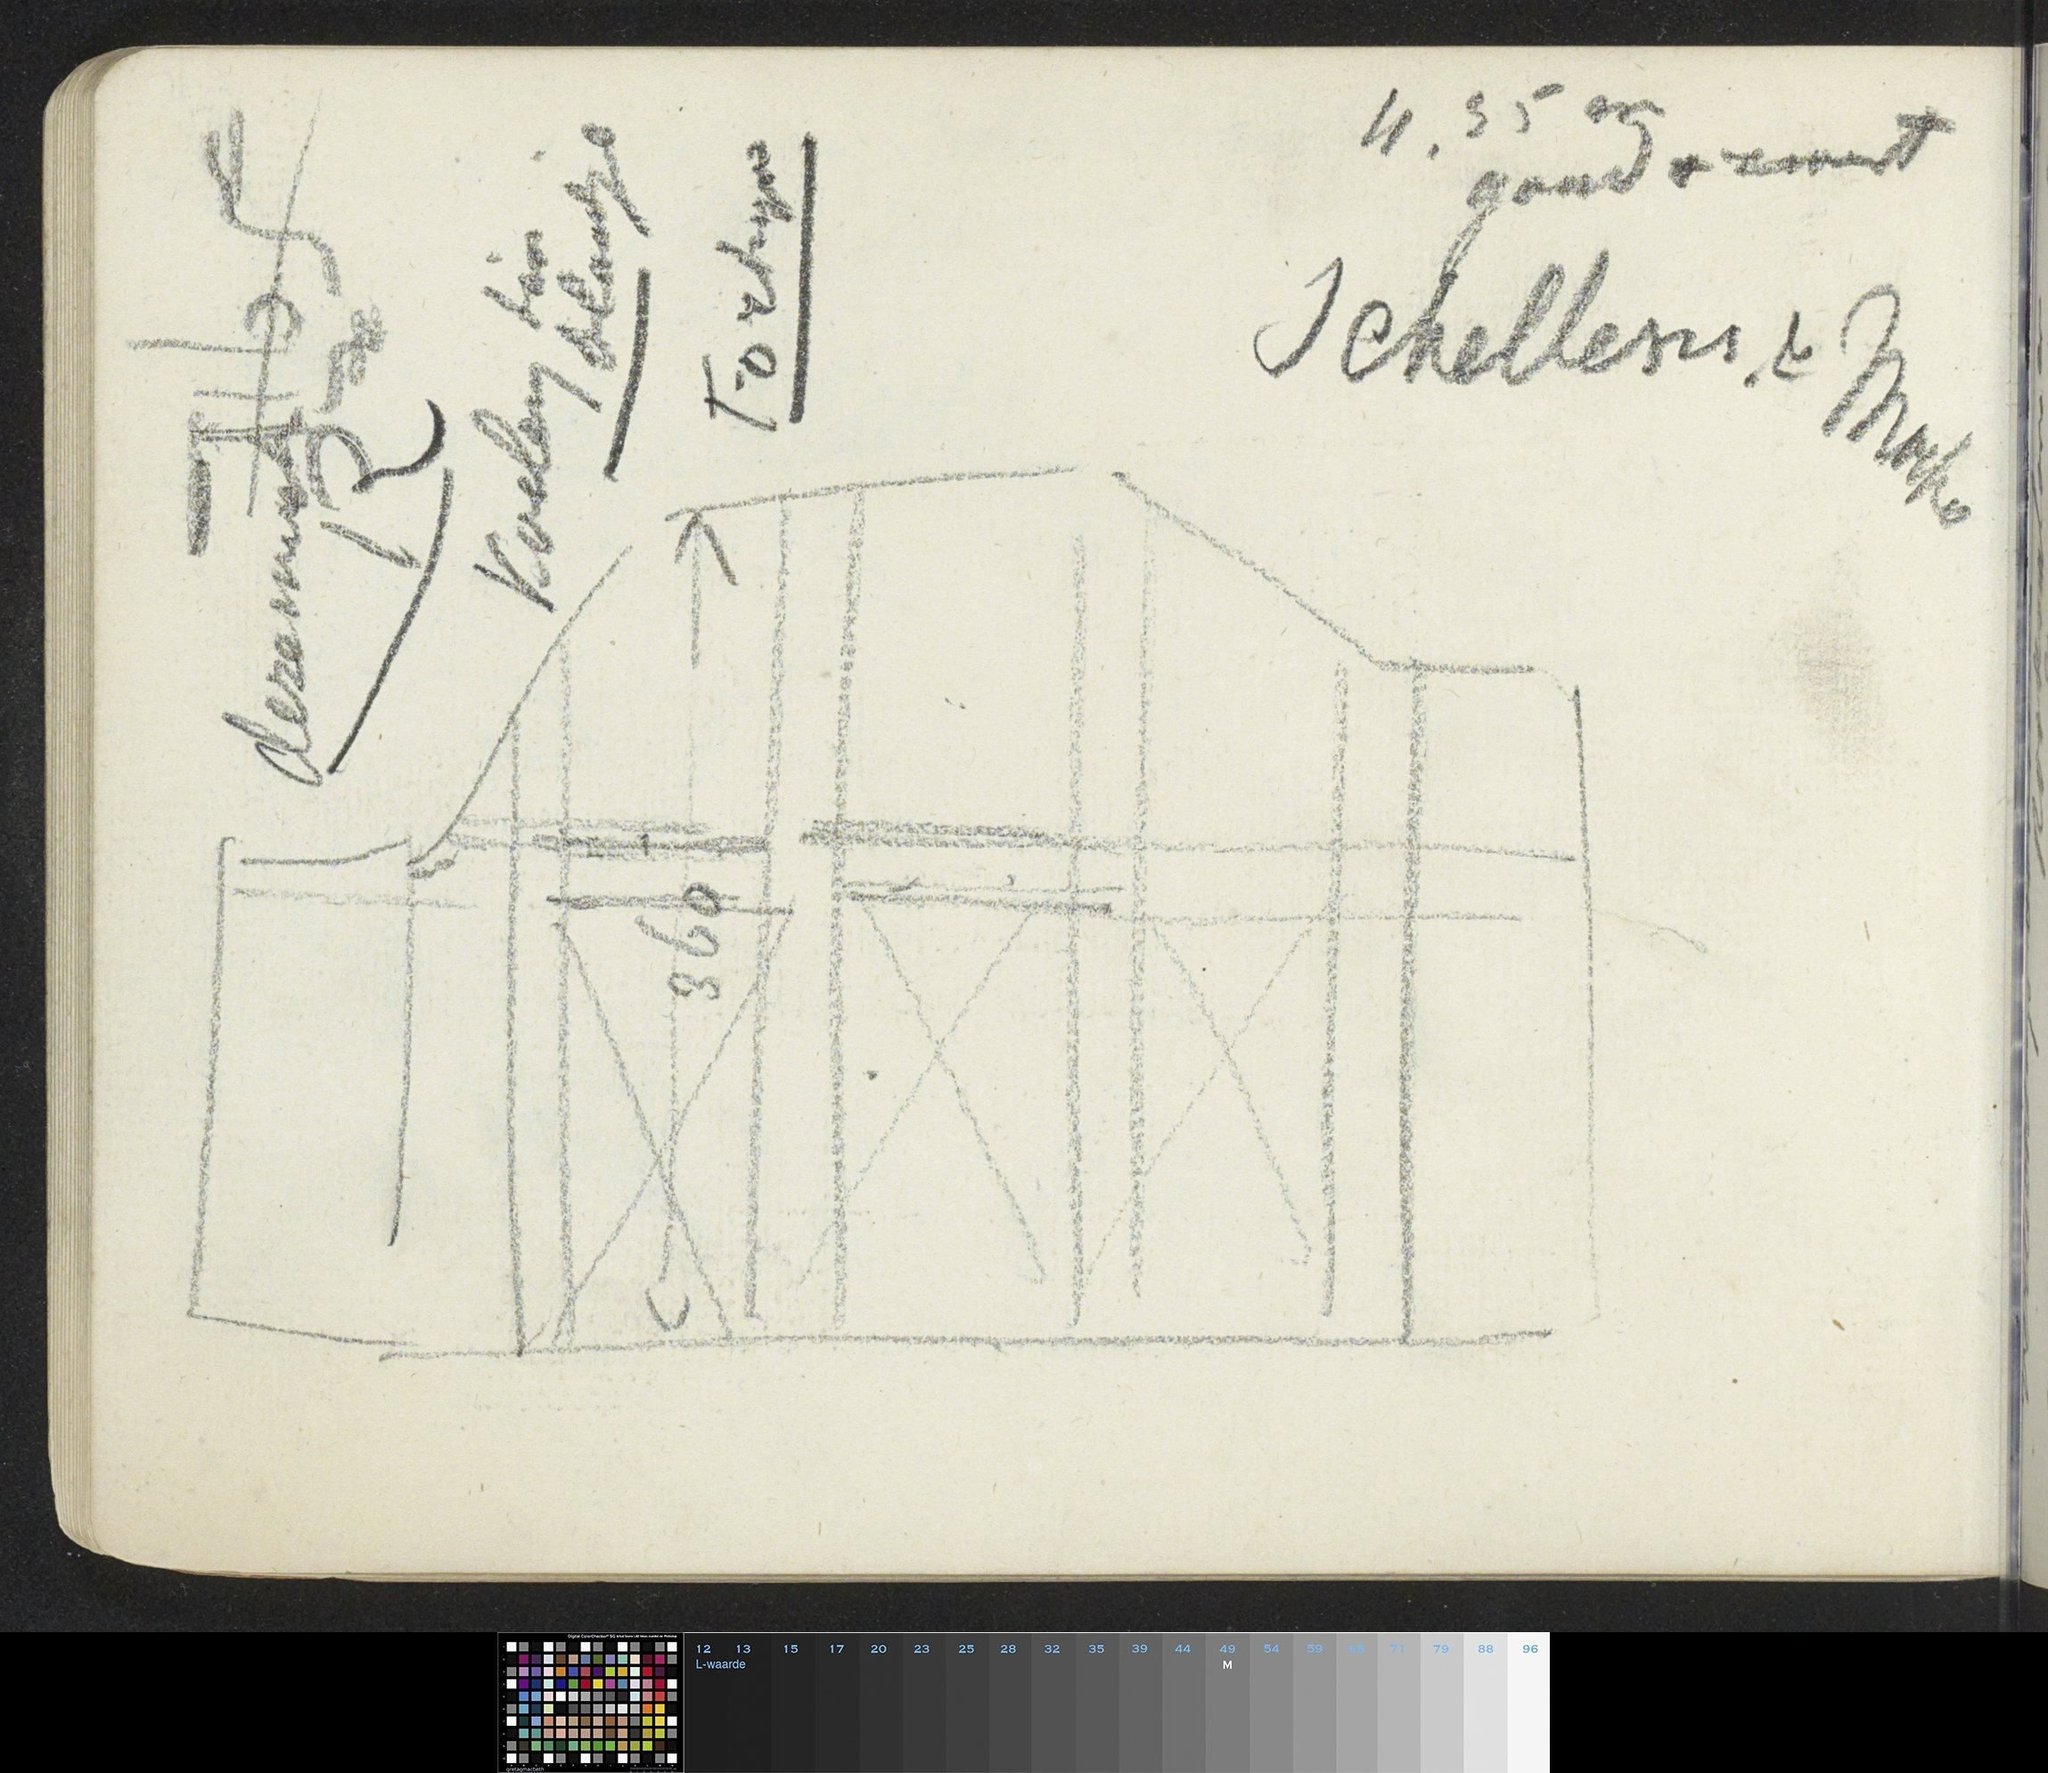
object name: sketchbook leaf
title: Ontwerp voor een wandbespanning of kamerscherm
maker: carel adolph lion cachet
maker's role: draughtsman, print maker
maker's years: 1864-1945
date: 1928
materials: paper, pencil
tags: screen, folding screen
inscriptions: annotation: ‘[...]’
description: Blad 13 verso uit een schetsboek met 24 bladen.